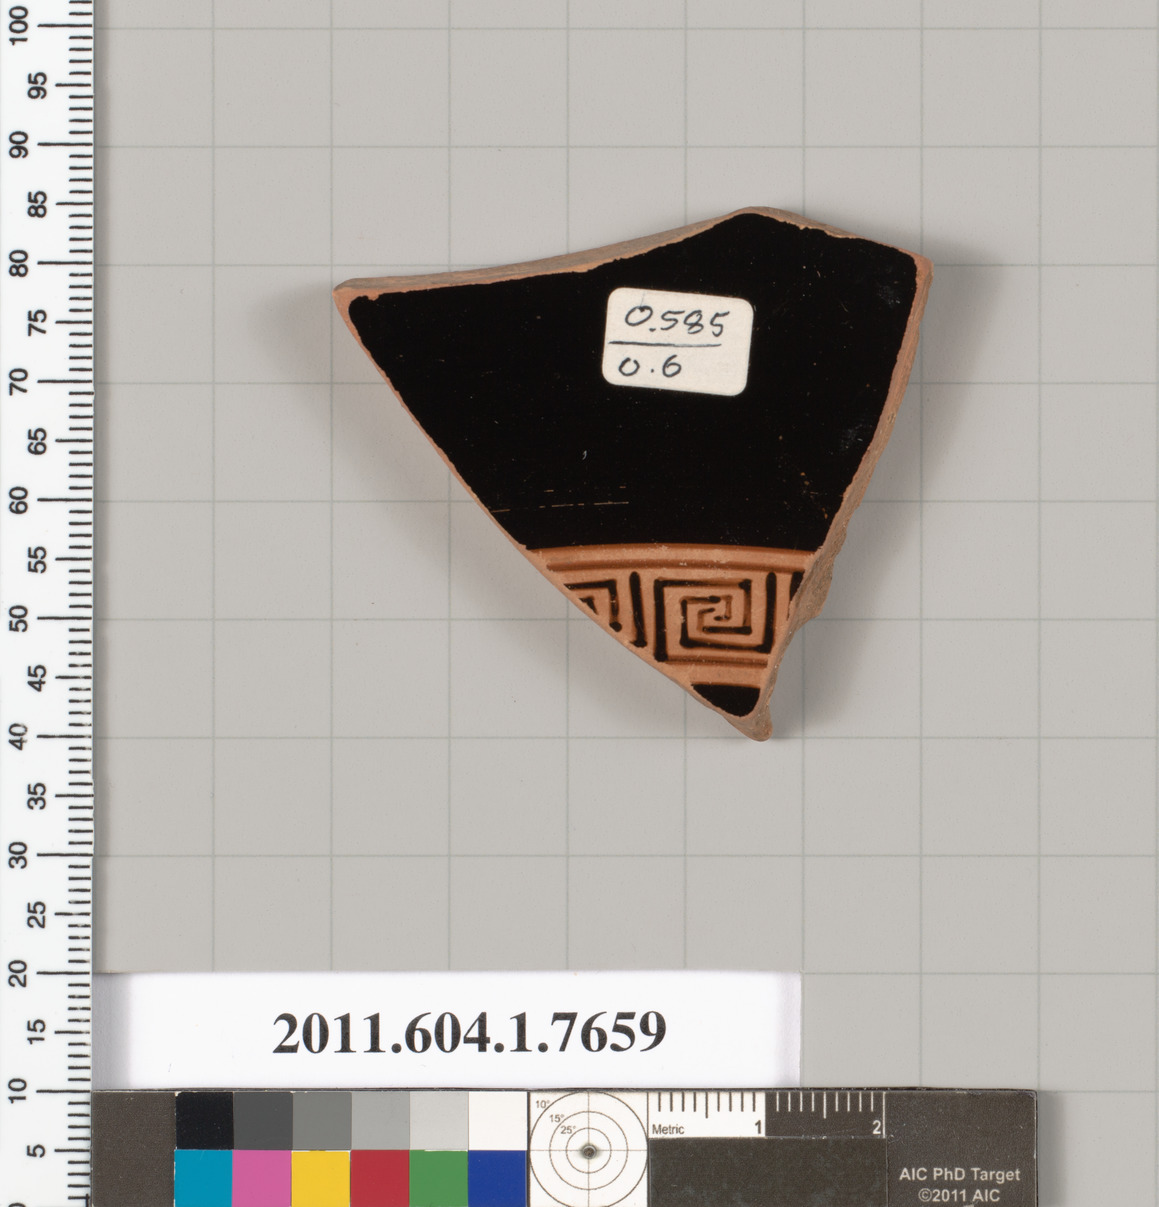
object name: kylix fragment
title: Terracotta fragment of a kylix (drinking cup)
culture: greek, attic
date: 460-450 BCE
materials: terracotta